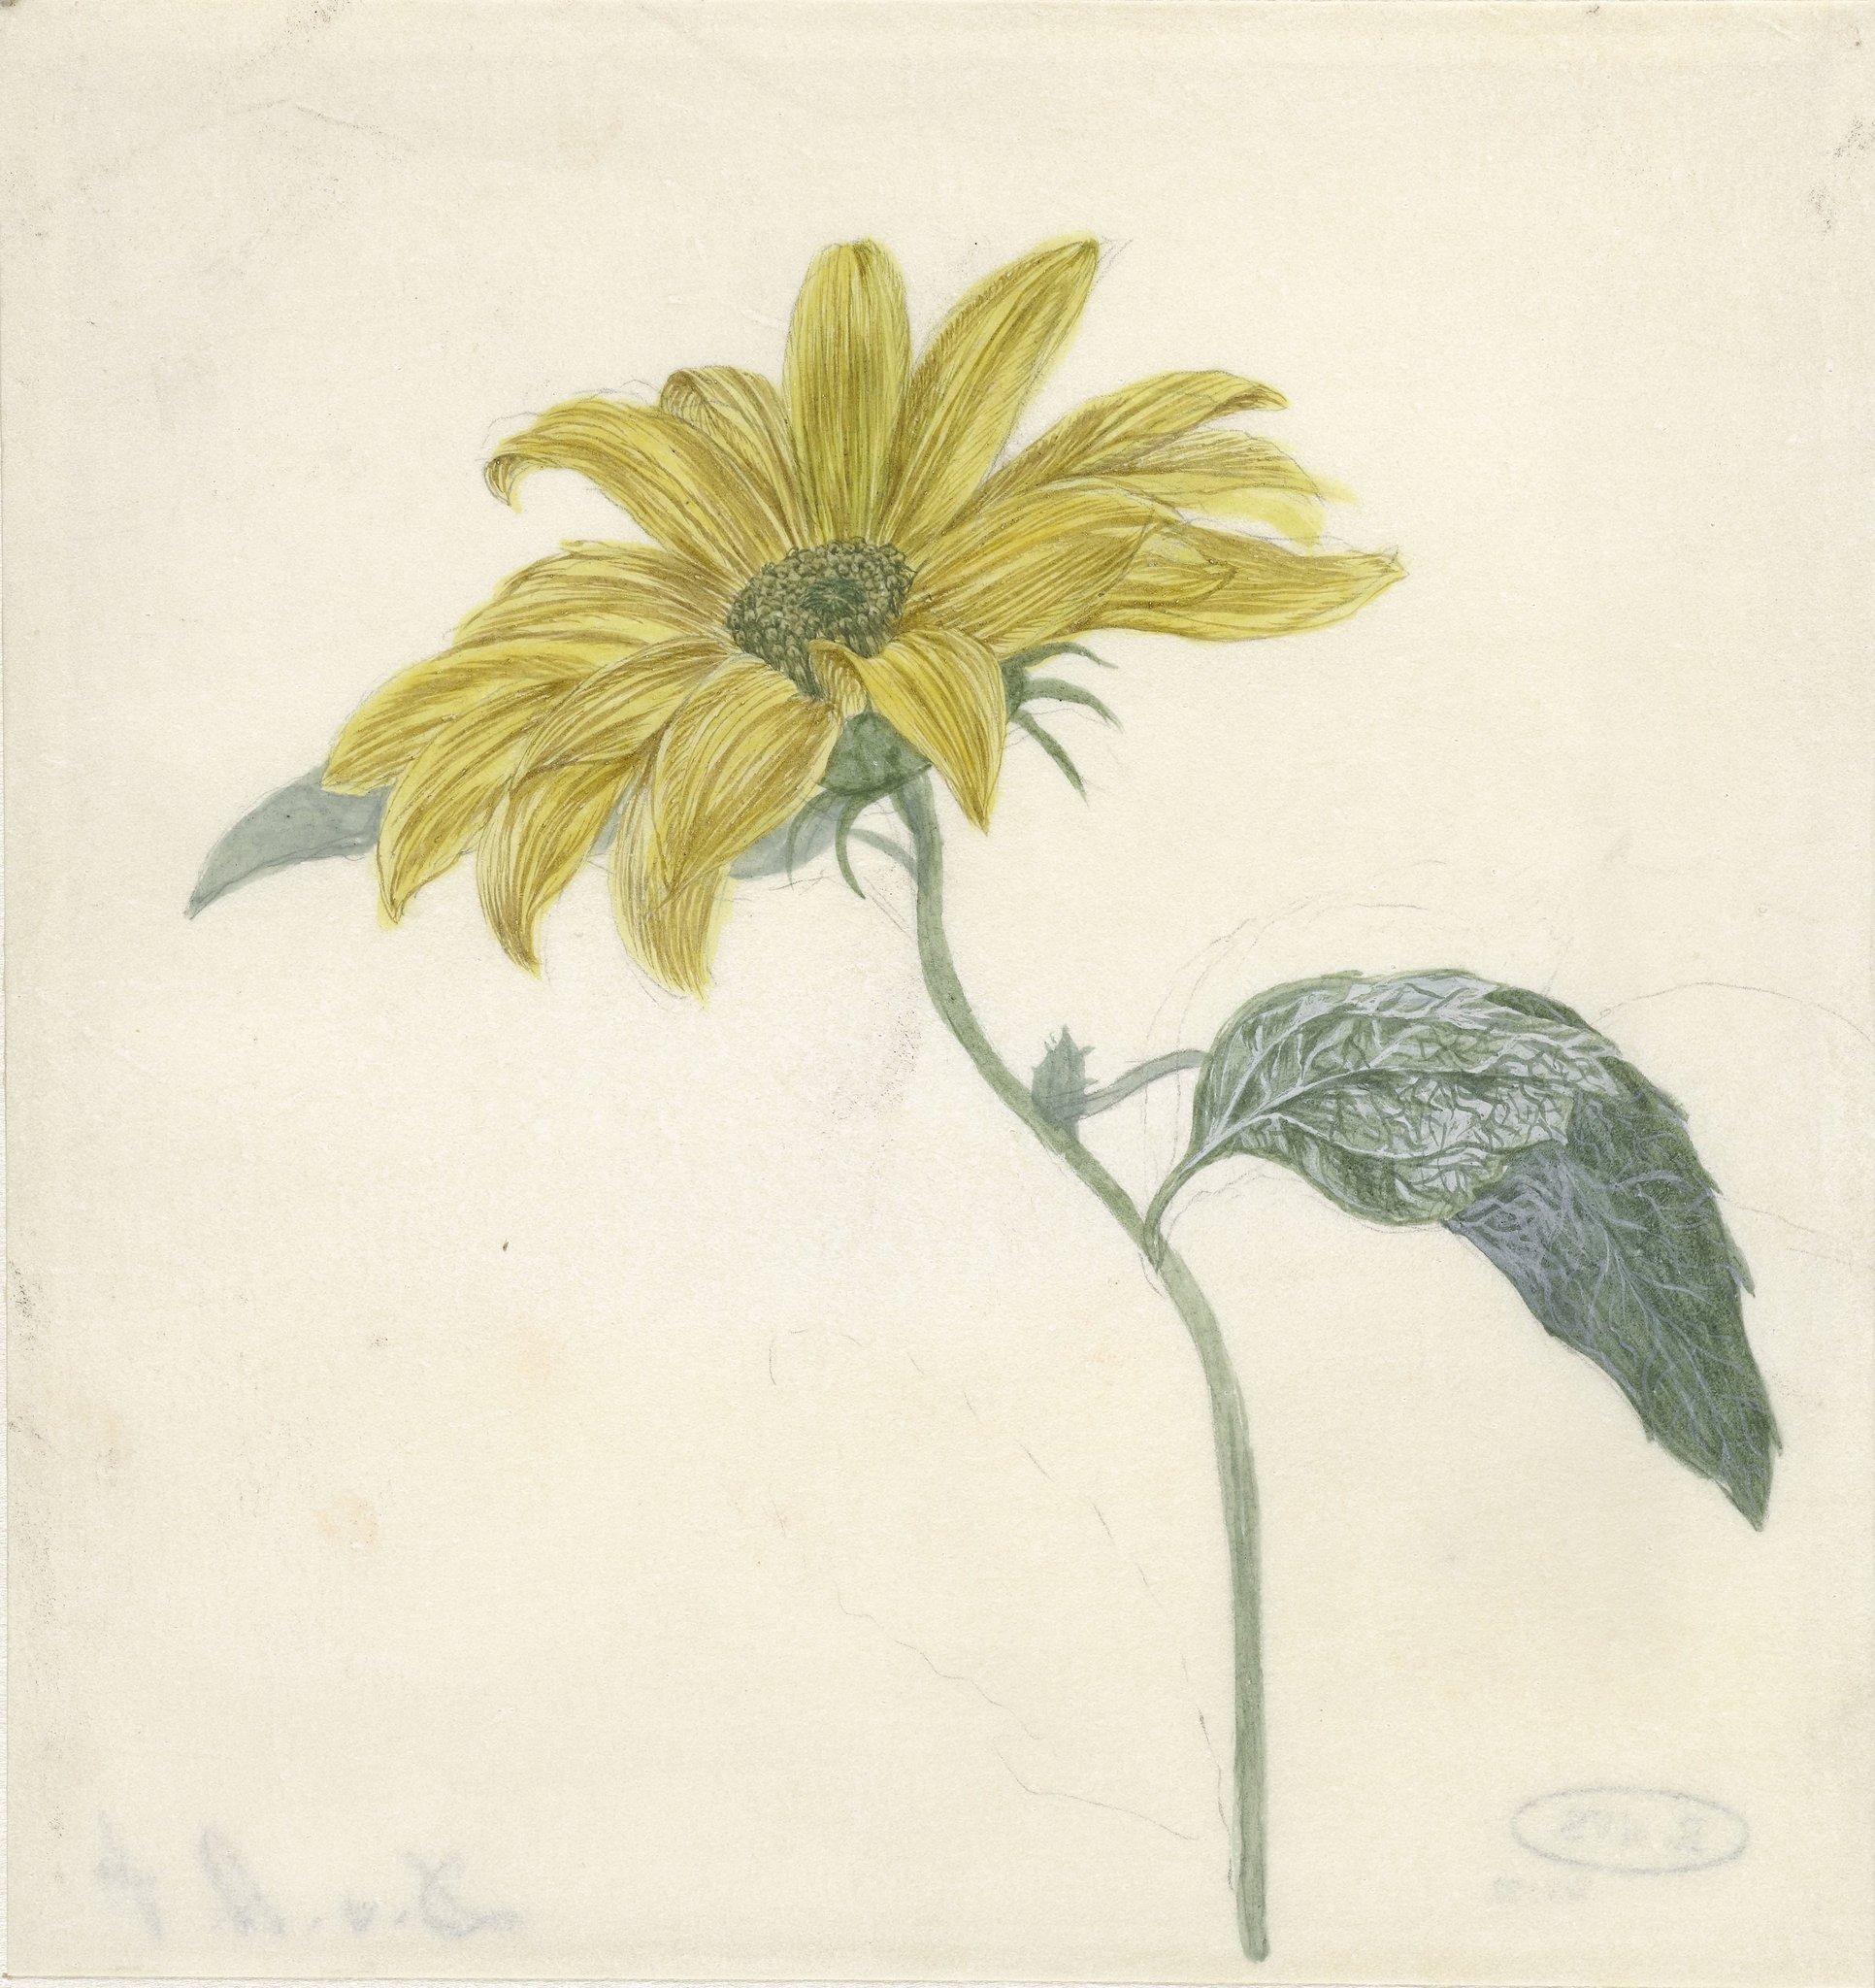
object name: watercolor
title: Zonnebloem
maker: d. van alphen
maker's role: draughtsman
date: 1800-1900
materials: ink, parchment, pencil, watercolor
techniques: brush, pen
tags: flowers: sunflower